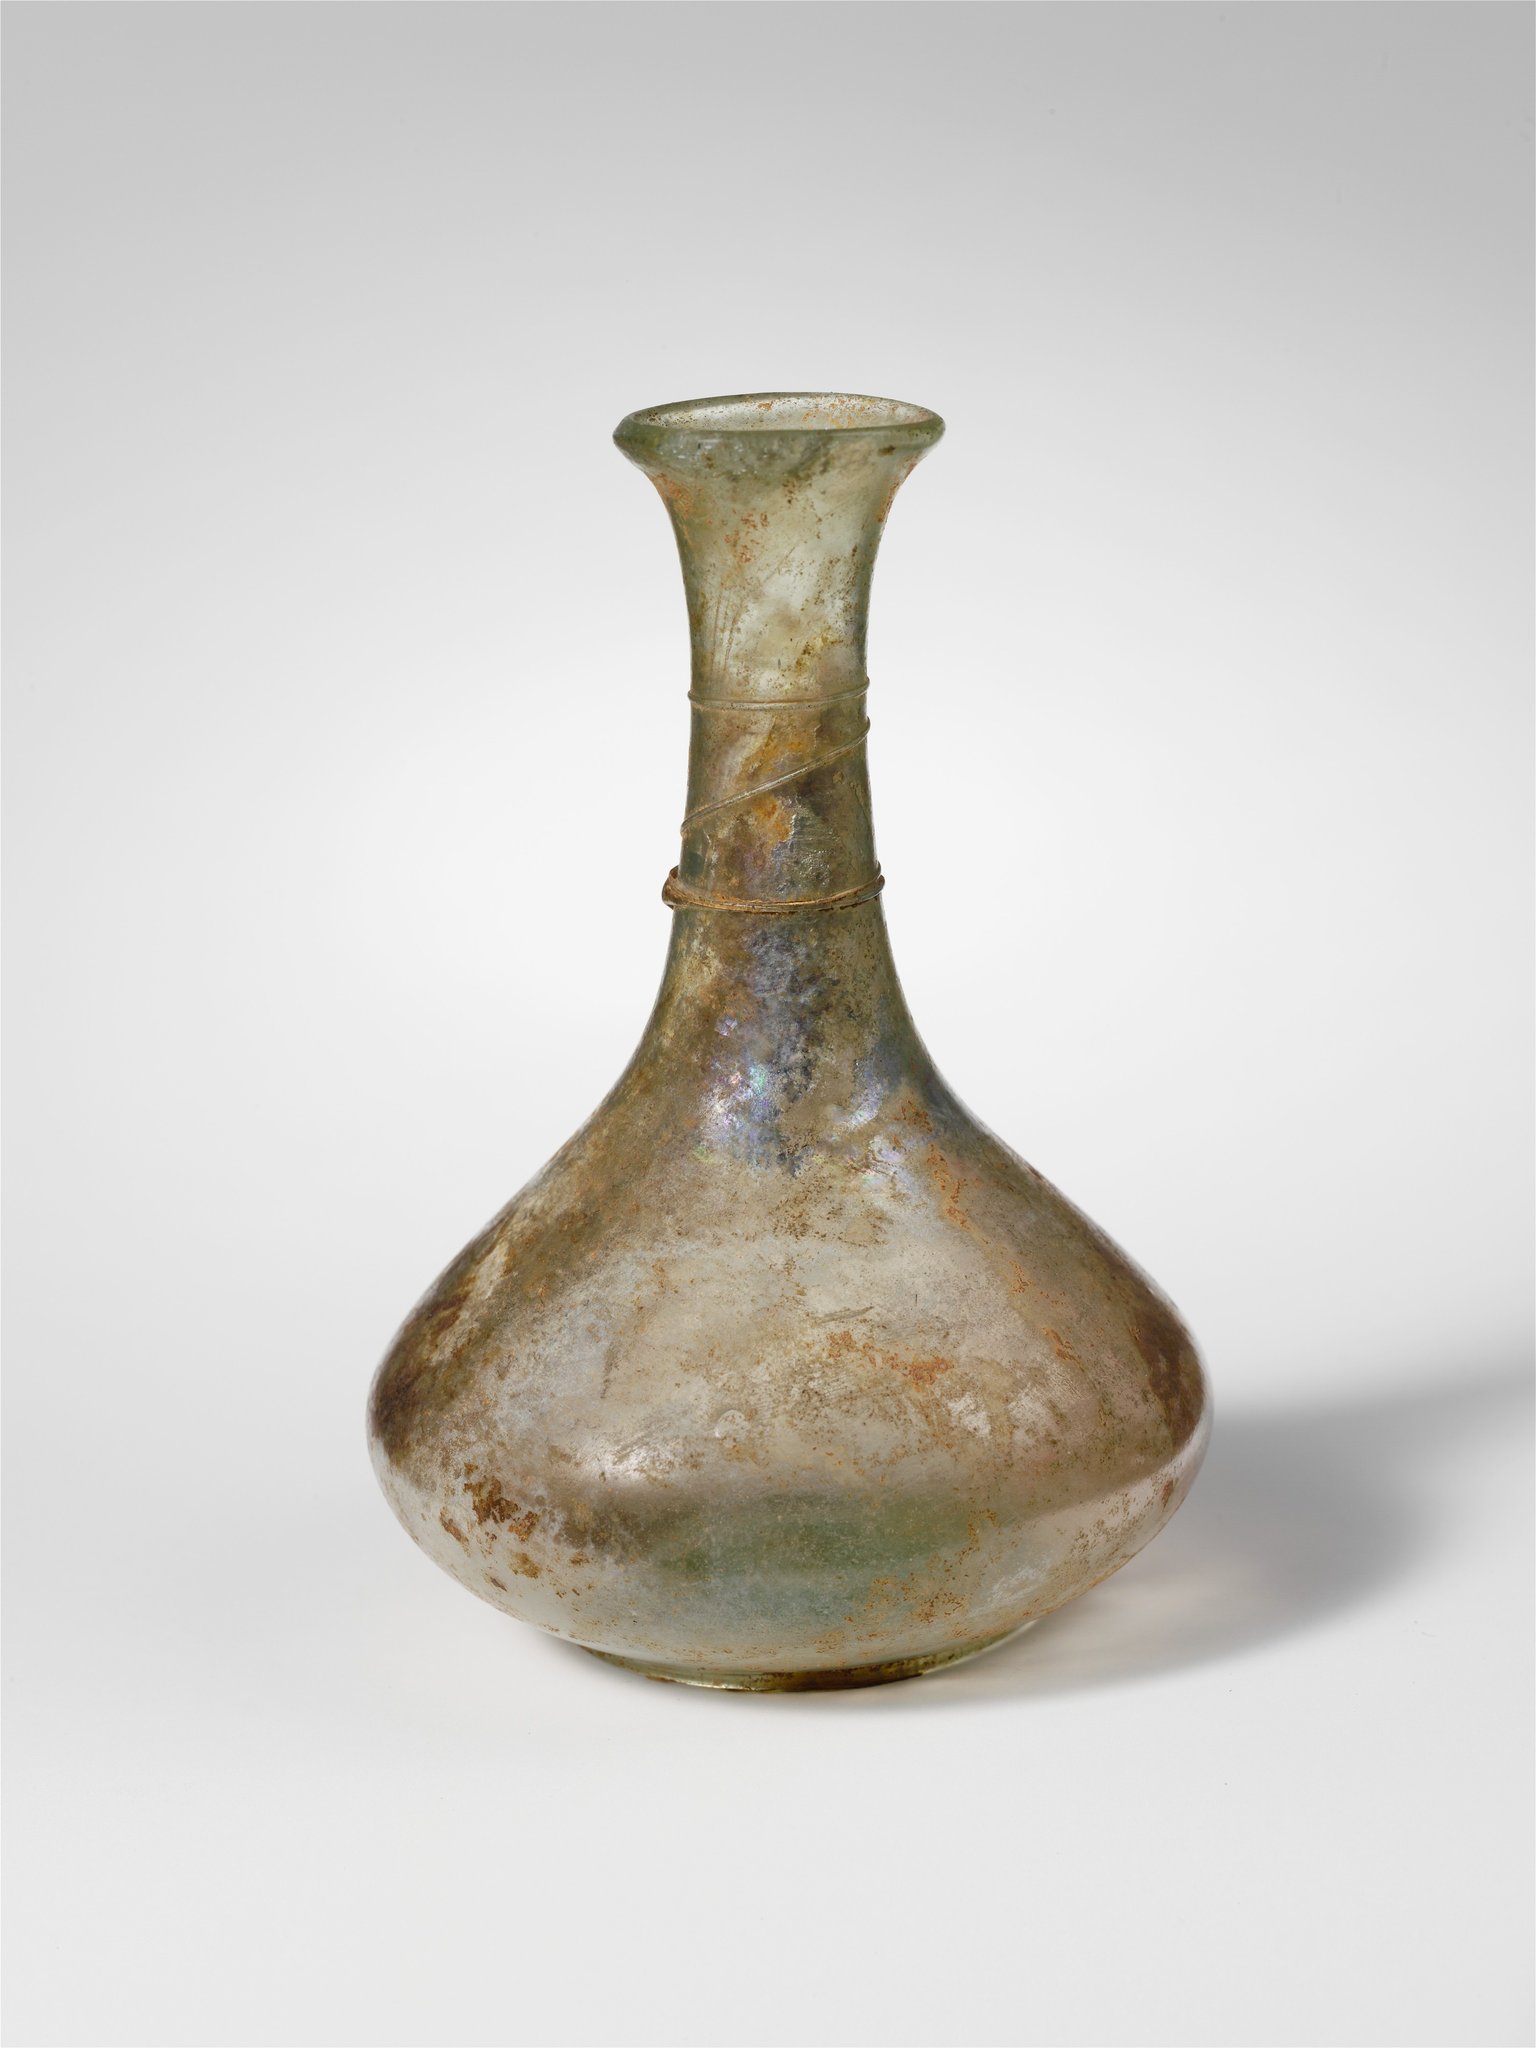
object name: flask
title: Glass flask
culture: roman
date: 201-400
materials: glass